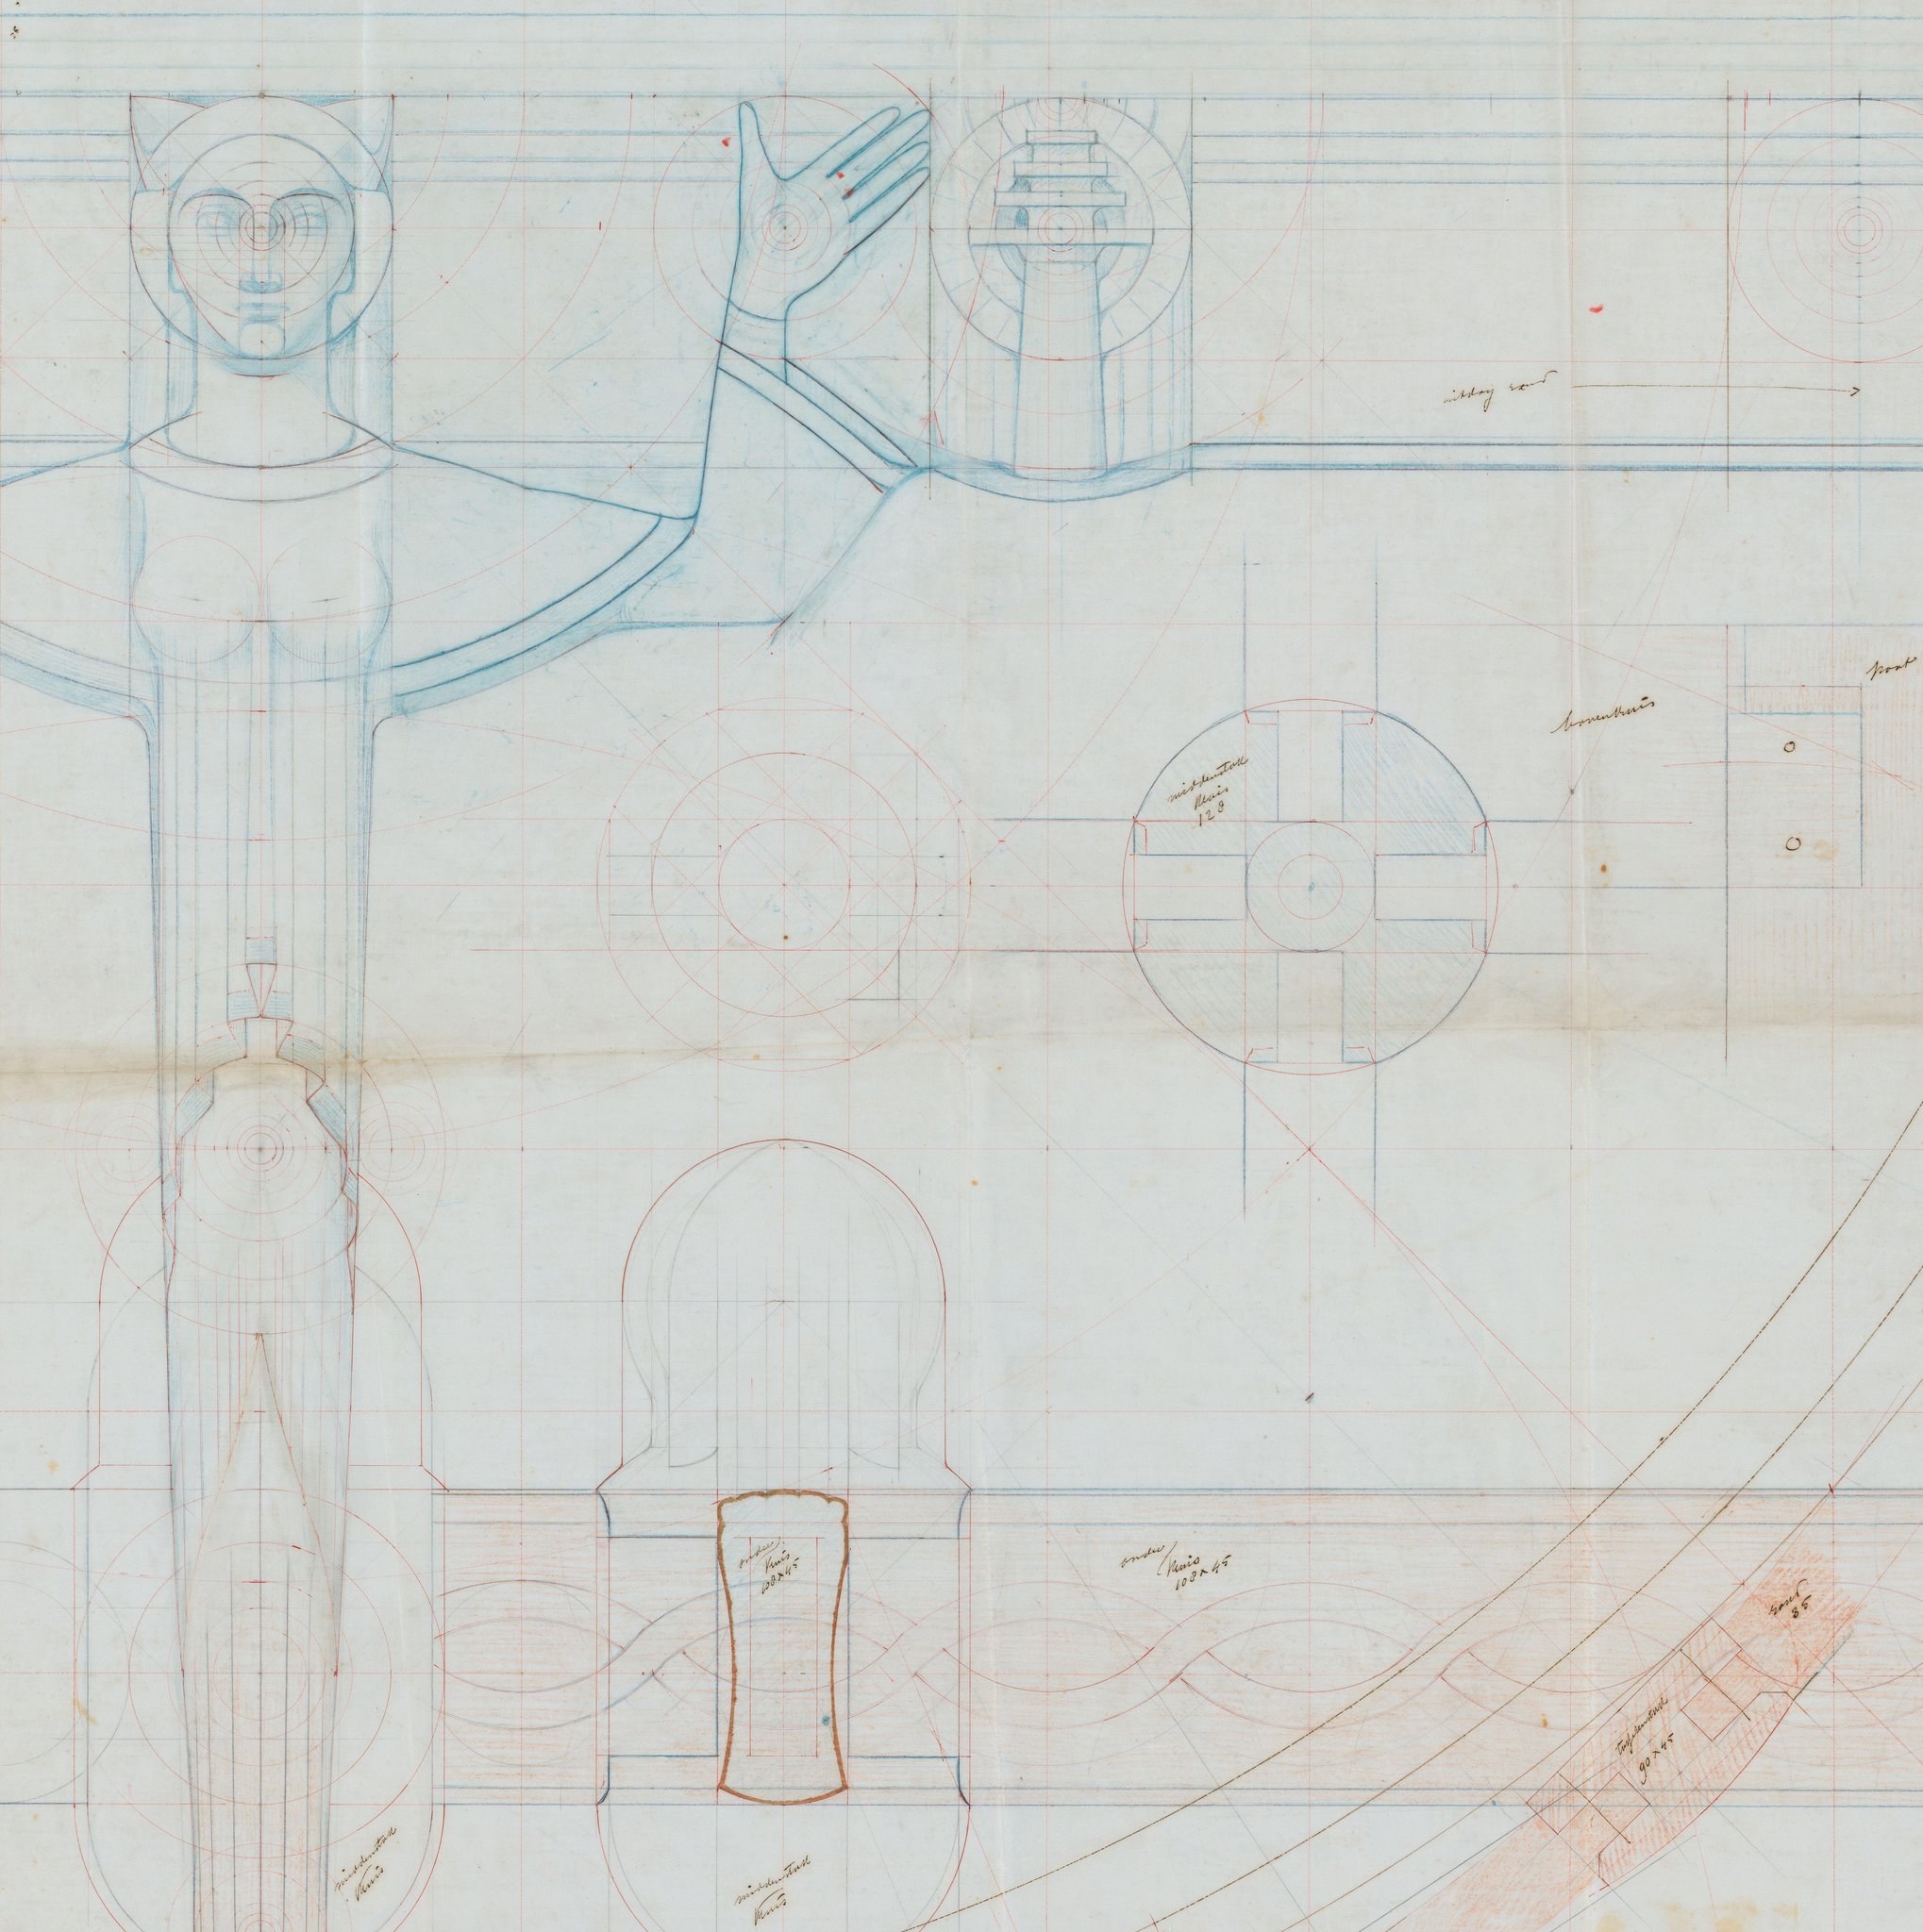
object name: drawing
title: Ontwerp voor een tafel voor J.P.W. Schuurman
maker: mathieu lauweriks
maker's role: designer, draughtsman, print maker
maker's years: 1864-1932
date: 1898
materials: chalk, ink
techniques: brush, pen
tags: table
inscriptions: collector's mark: Lugt 2228, annotation:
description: Ontwerp voor J.P.W. Schuurman te Den Haag.